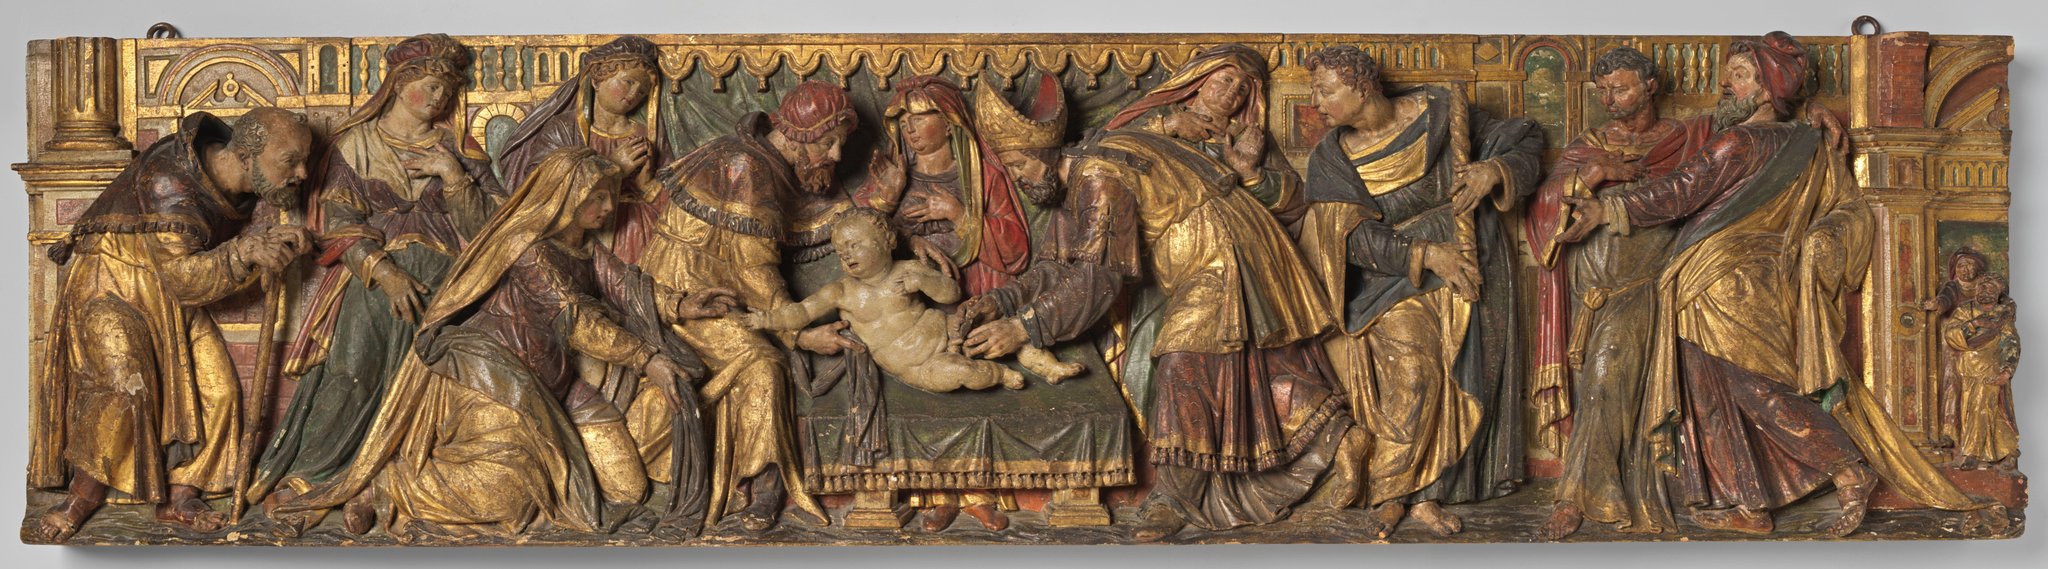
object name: sculpture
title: The Circumcision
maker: Anonymous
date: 1540-1560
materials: wood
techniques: polychromy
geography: liège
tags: circumcision of the christ-child by the priest in the temple (luke 2:21)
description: The Circumcision. Limewood with original polychromy. French Flanders (?), c. 1560 - 1570.